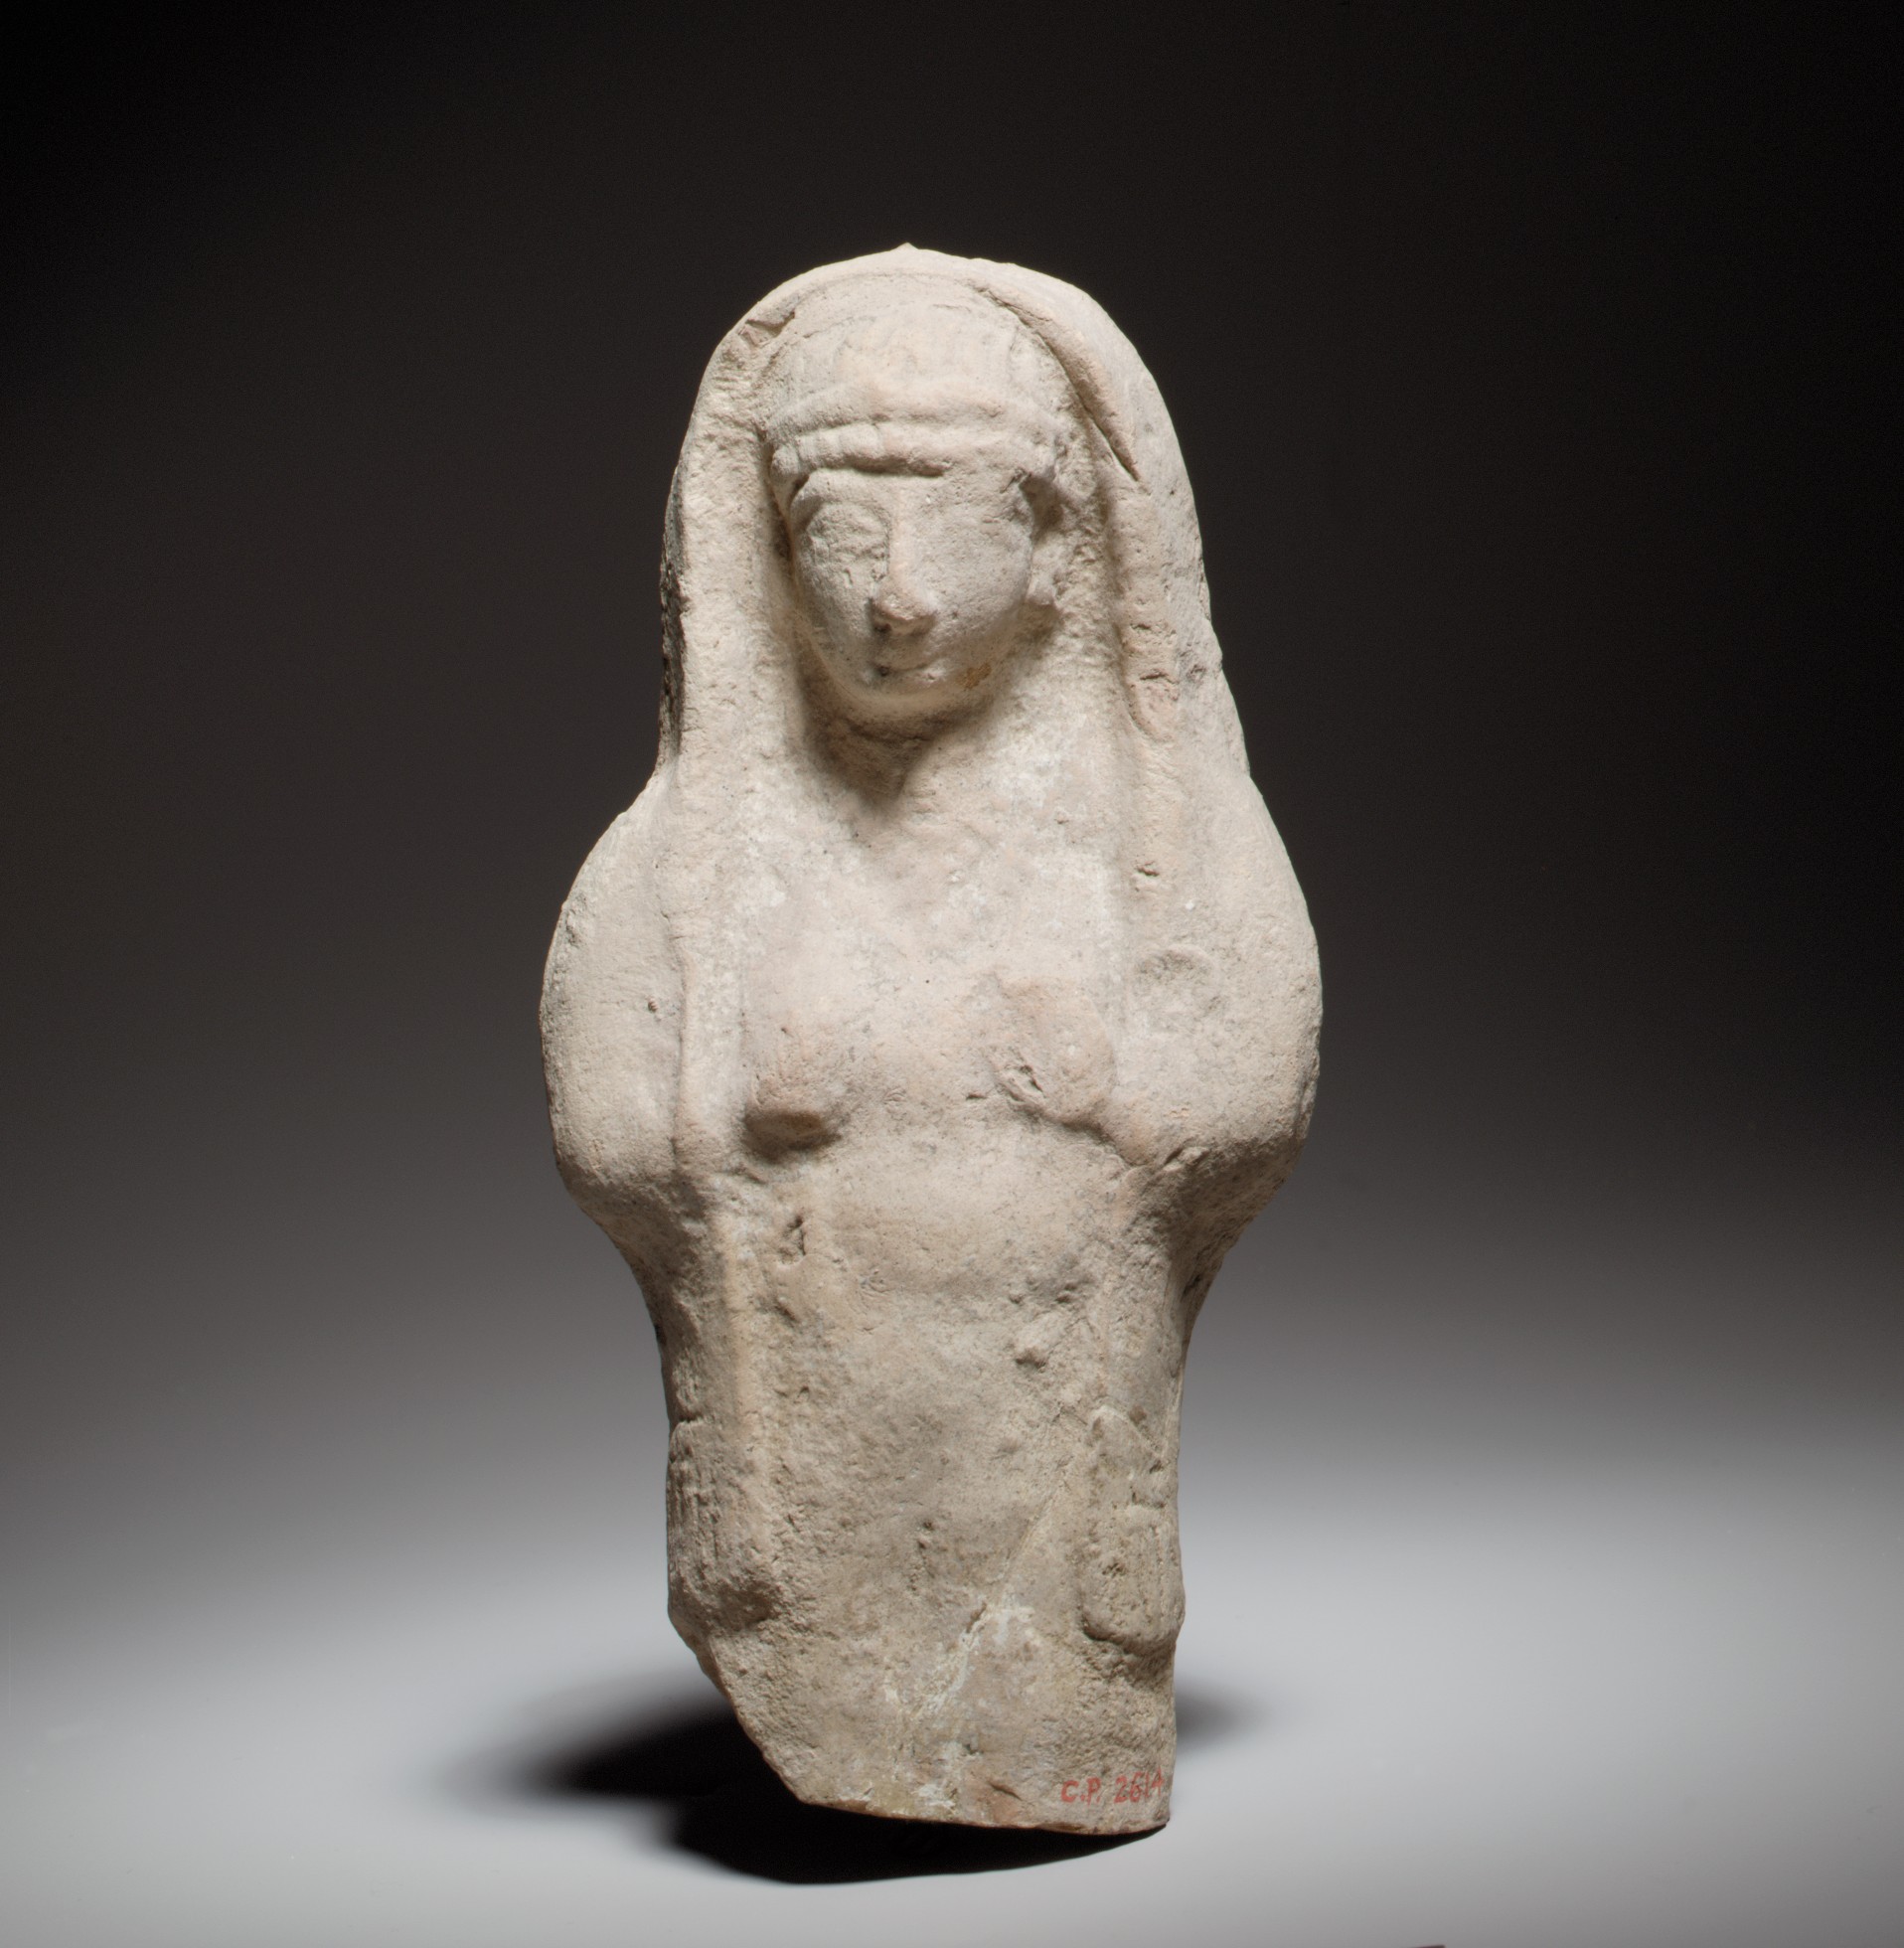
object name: statuette of a woman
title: Standing female figurine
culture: cypriot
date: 534-468 BCE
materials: terracotta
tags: women